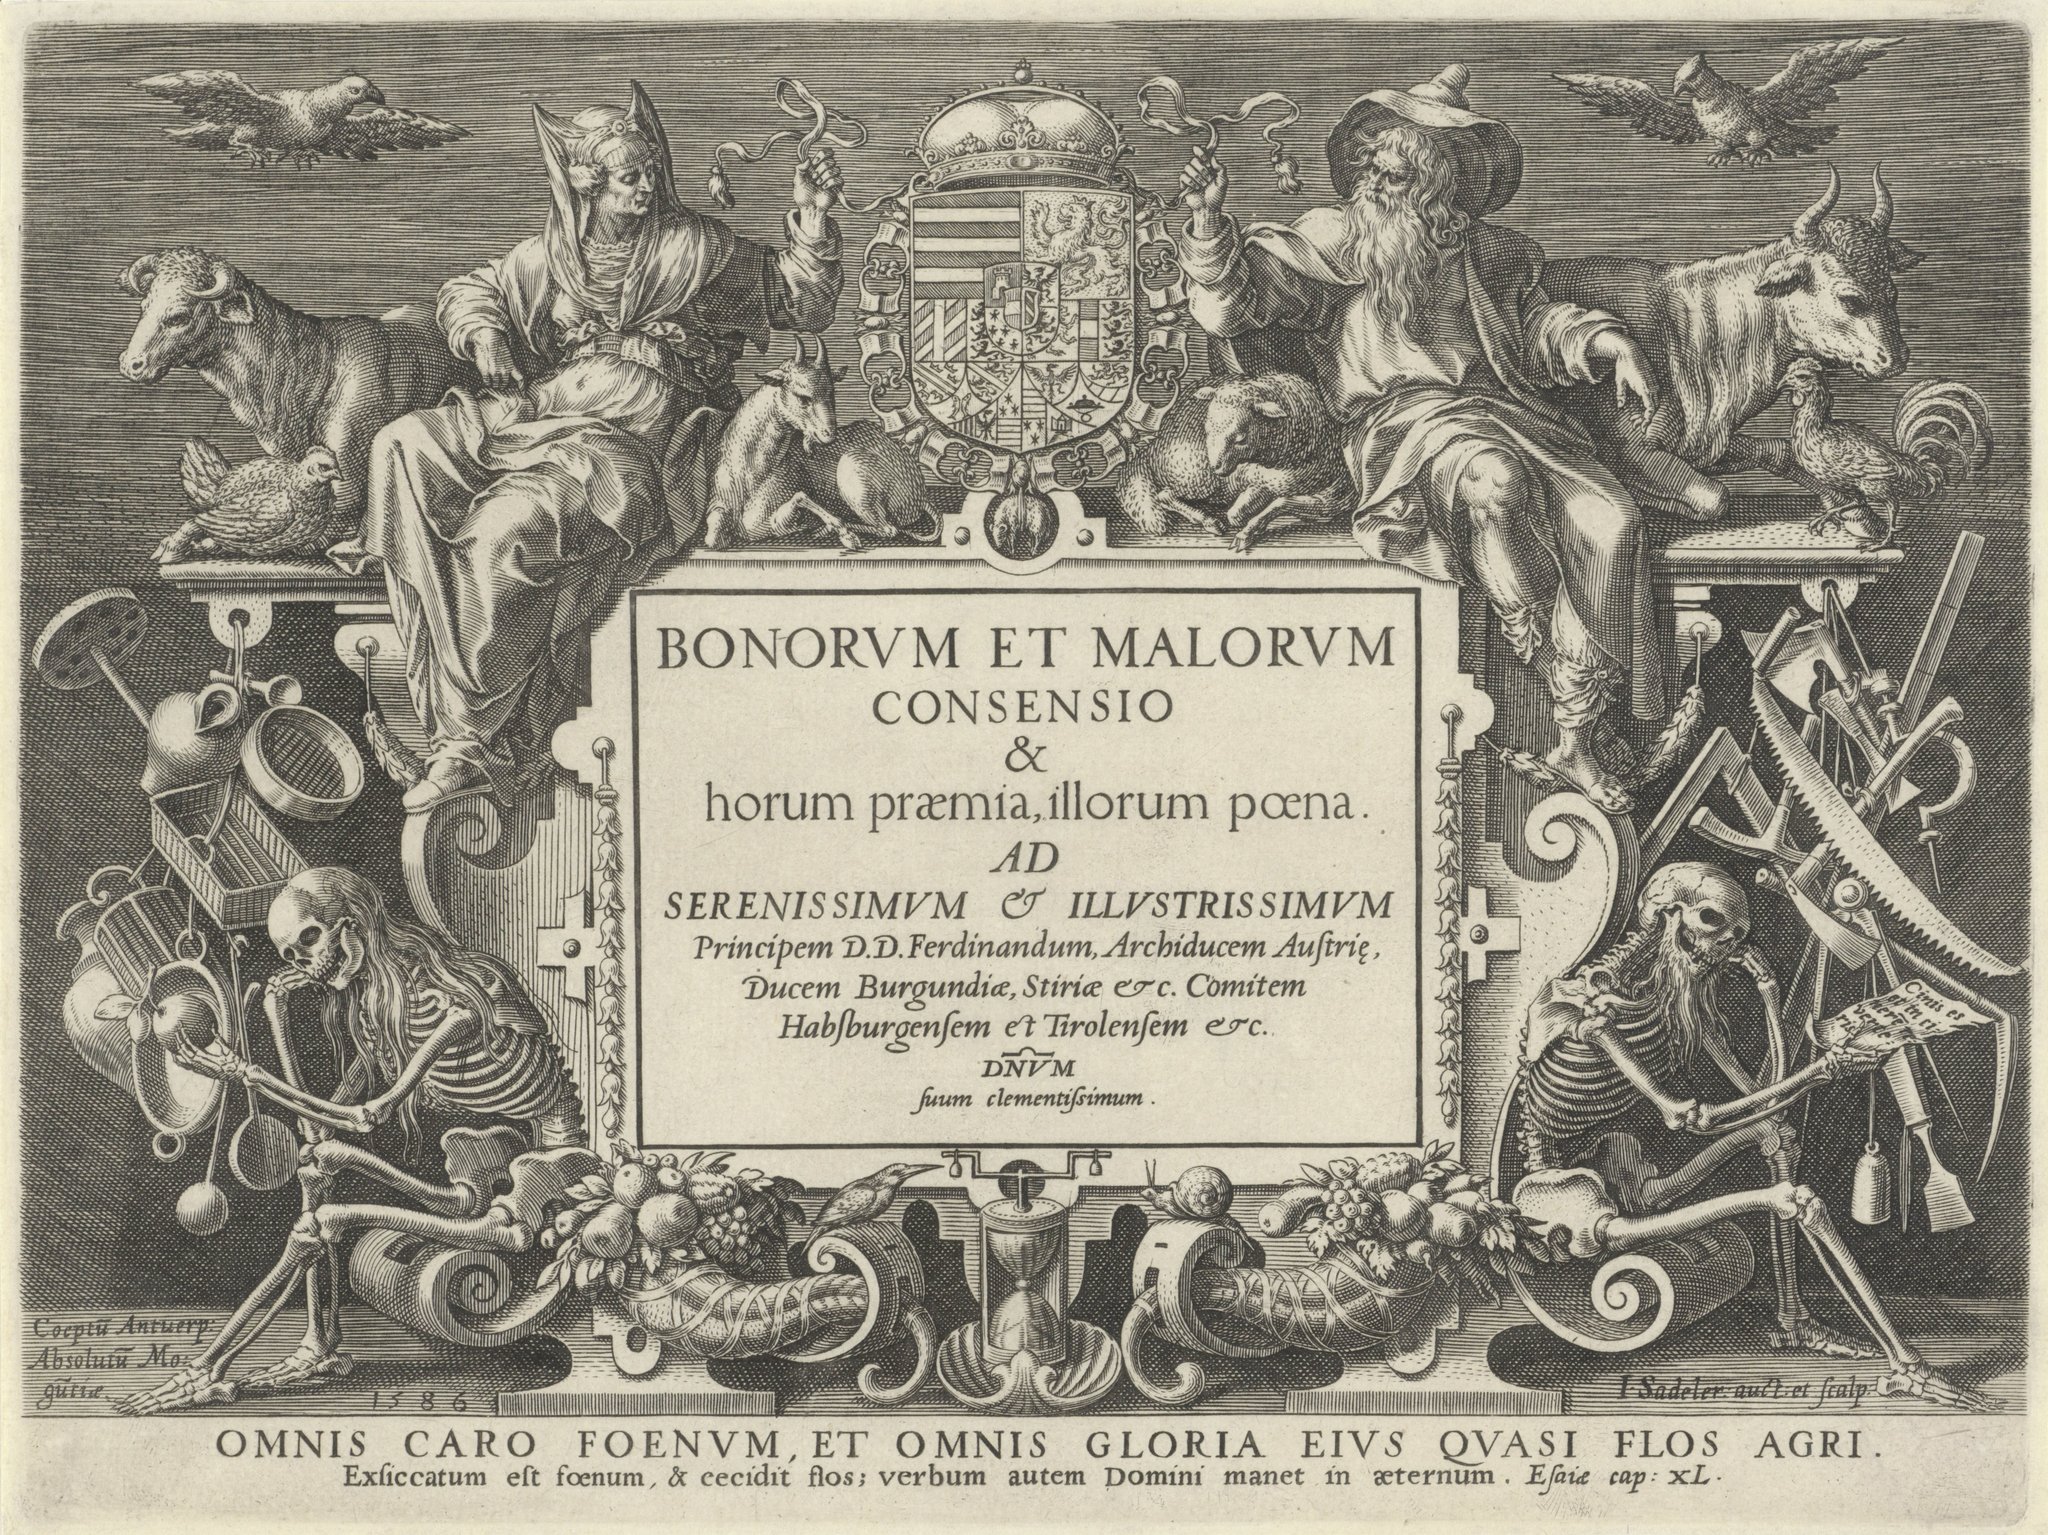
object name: print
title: Bonorvm et Malorvm consensio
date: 1586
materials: paper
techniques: engraving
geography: antwerp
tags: musical instruments; group of musical instruments, adam and eve (not in biblical context) - post-mortem occurrences of male persons from the old testament, e.g. finding and transportation of relics, story of seth, 'cornucopia', horn of plenty, title-page, agricultural implements, male persons from the old testament (with name) (not in biblical context)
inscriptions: collector's mark: Lugt 2228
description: Titel in een ornamentele lijst opgebouwd uit twee hoorns van overvloed, landbouwwerktuigen en links en rechts de skeletten van Adam en Eva. Eva (links) kijkt naar de appel die de Zondeval veroorzaakte. Adam kijkt naar een blad met daarop het citaat 'Stof ben je, tot stof keer je terug' in het Latijn. Middenboven het wapenschild van Ferdinand II van Tirol, vastgehouden door Noach en zijn vrouw.